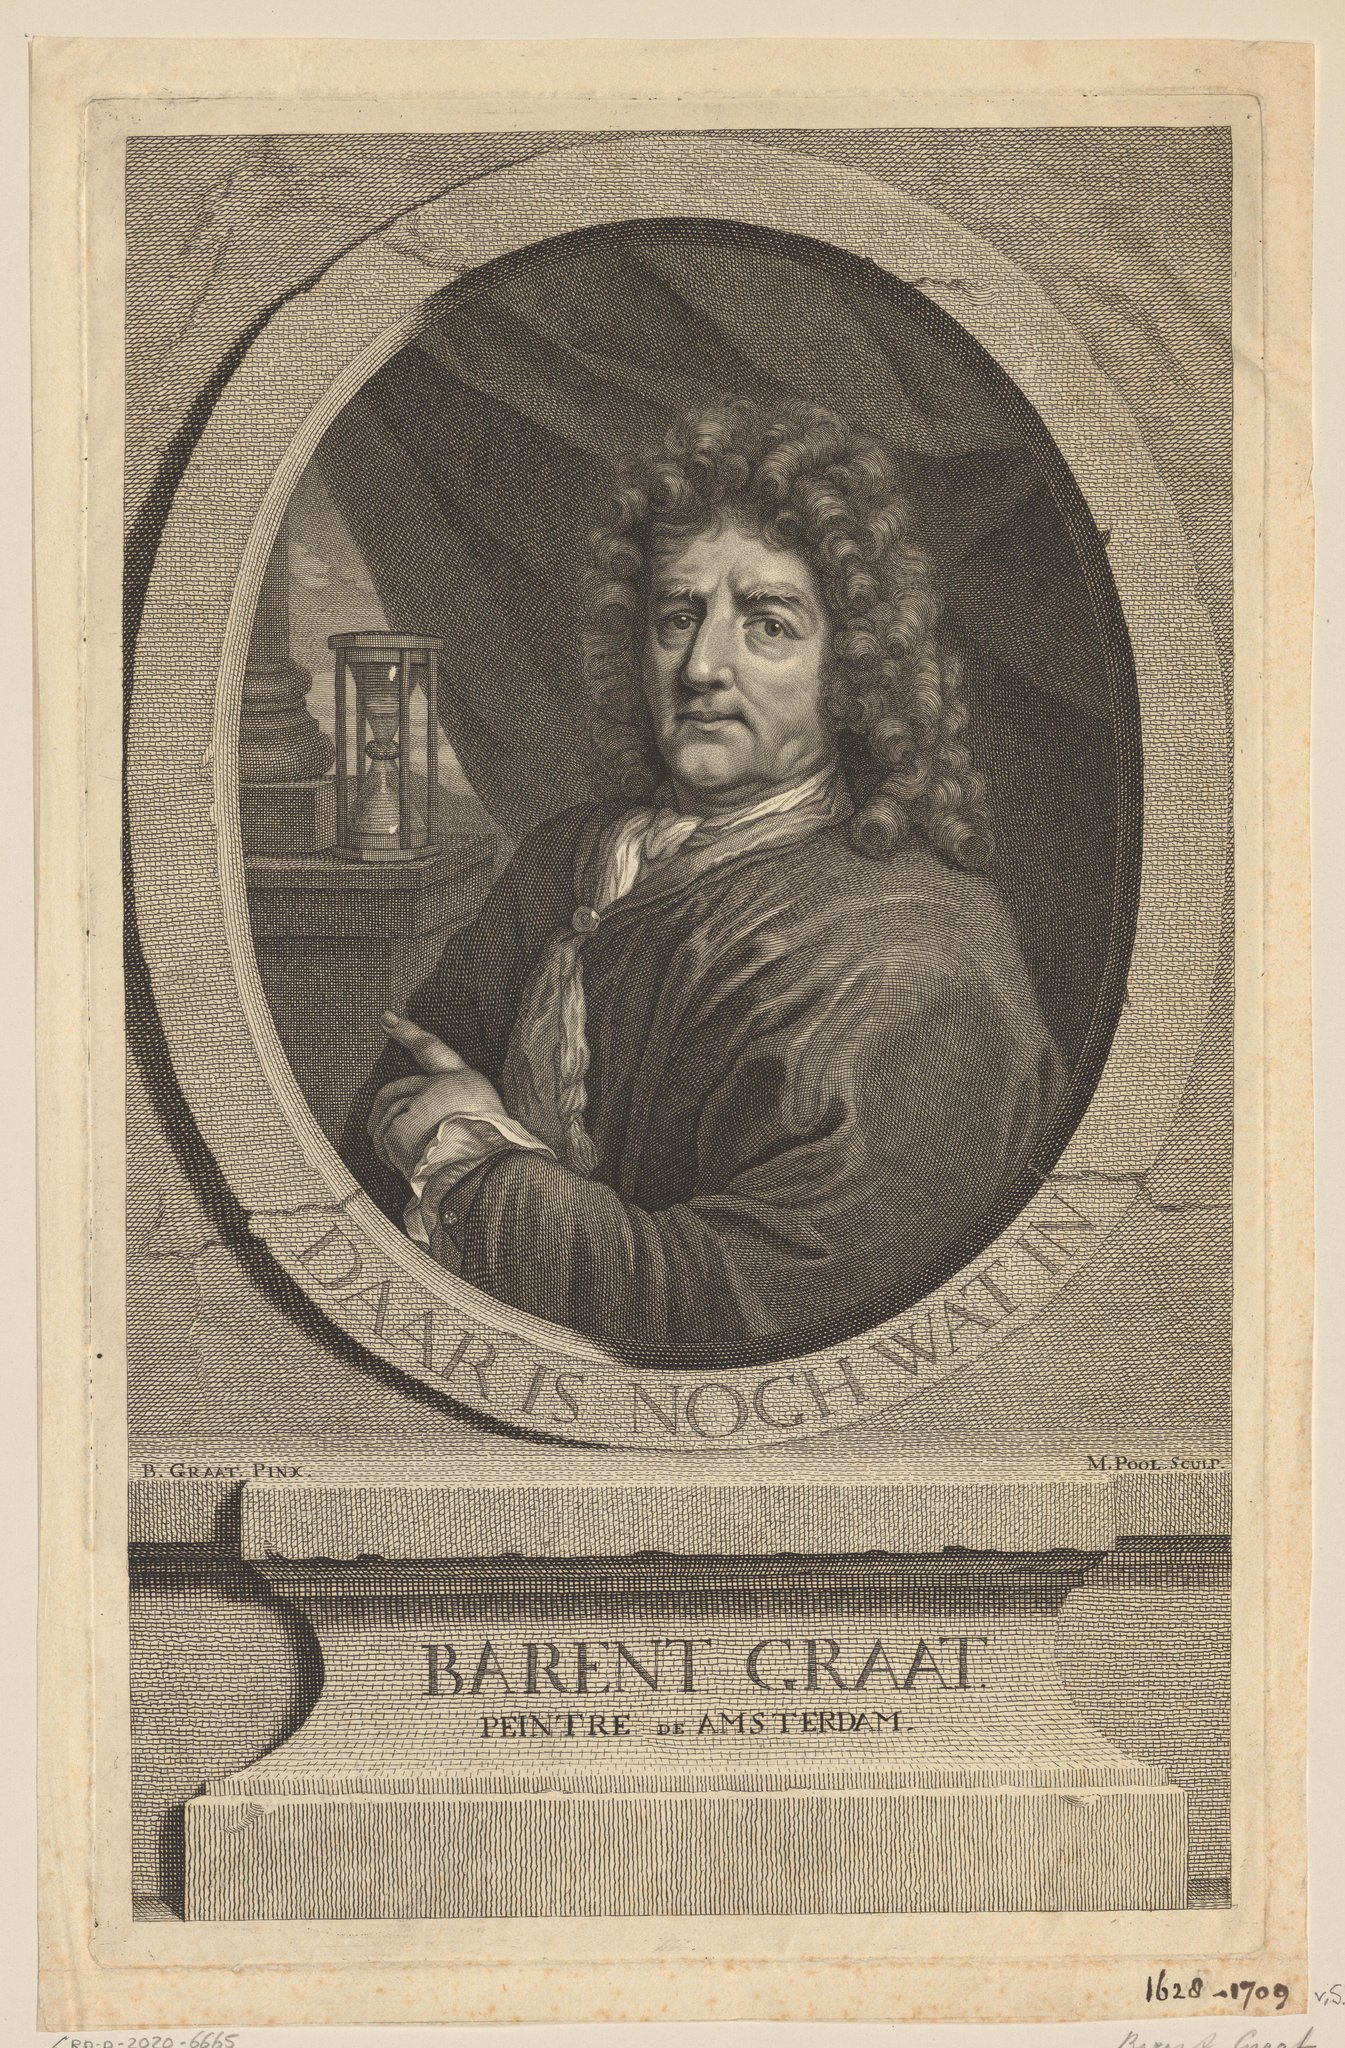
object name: print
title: Portret van Barend Graat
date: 1687-1727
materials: paper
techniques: engraving, etching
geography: amsterdam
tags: amsterdam, barend graat, historical persons, portrait, self-portrait of painter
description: Tekst in het Nederlands in de omlijsting.